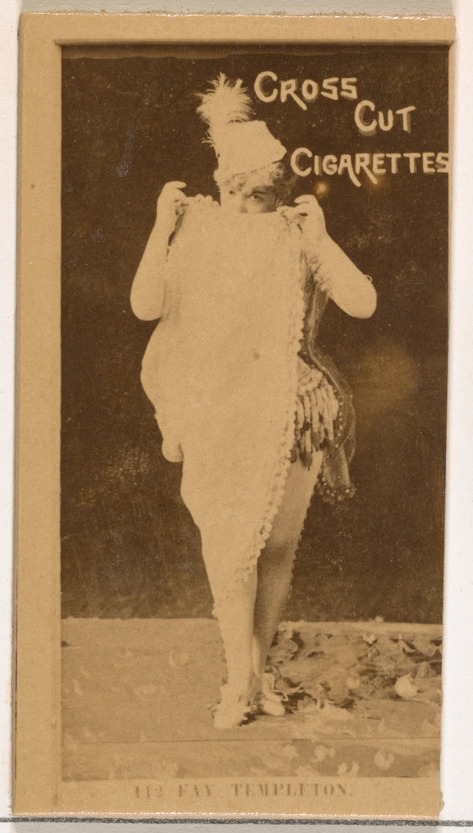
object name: print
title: Card Number 112, Fay Templeton, from the Actors and Actresses series (N145-2) issued by Duke Sons & Co. to promote Cross Cut Cigarettes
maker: w. duke, sons & co.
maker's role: publisher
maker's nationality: american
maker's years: 1870-1920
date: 1880-1889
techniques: albumen silver print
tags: portraits,women,actresses